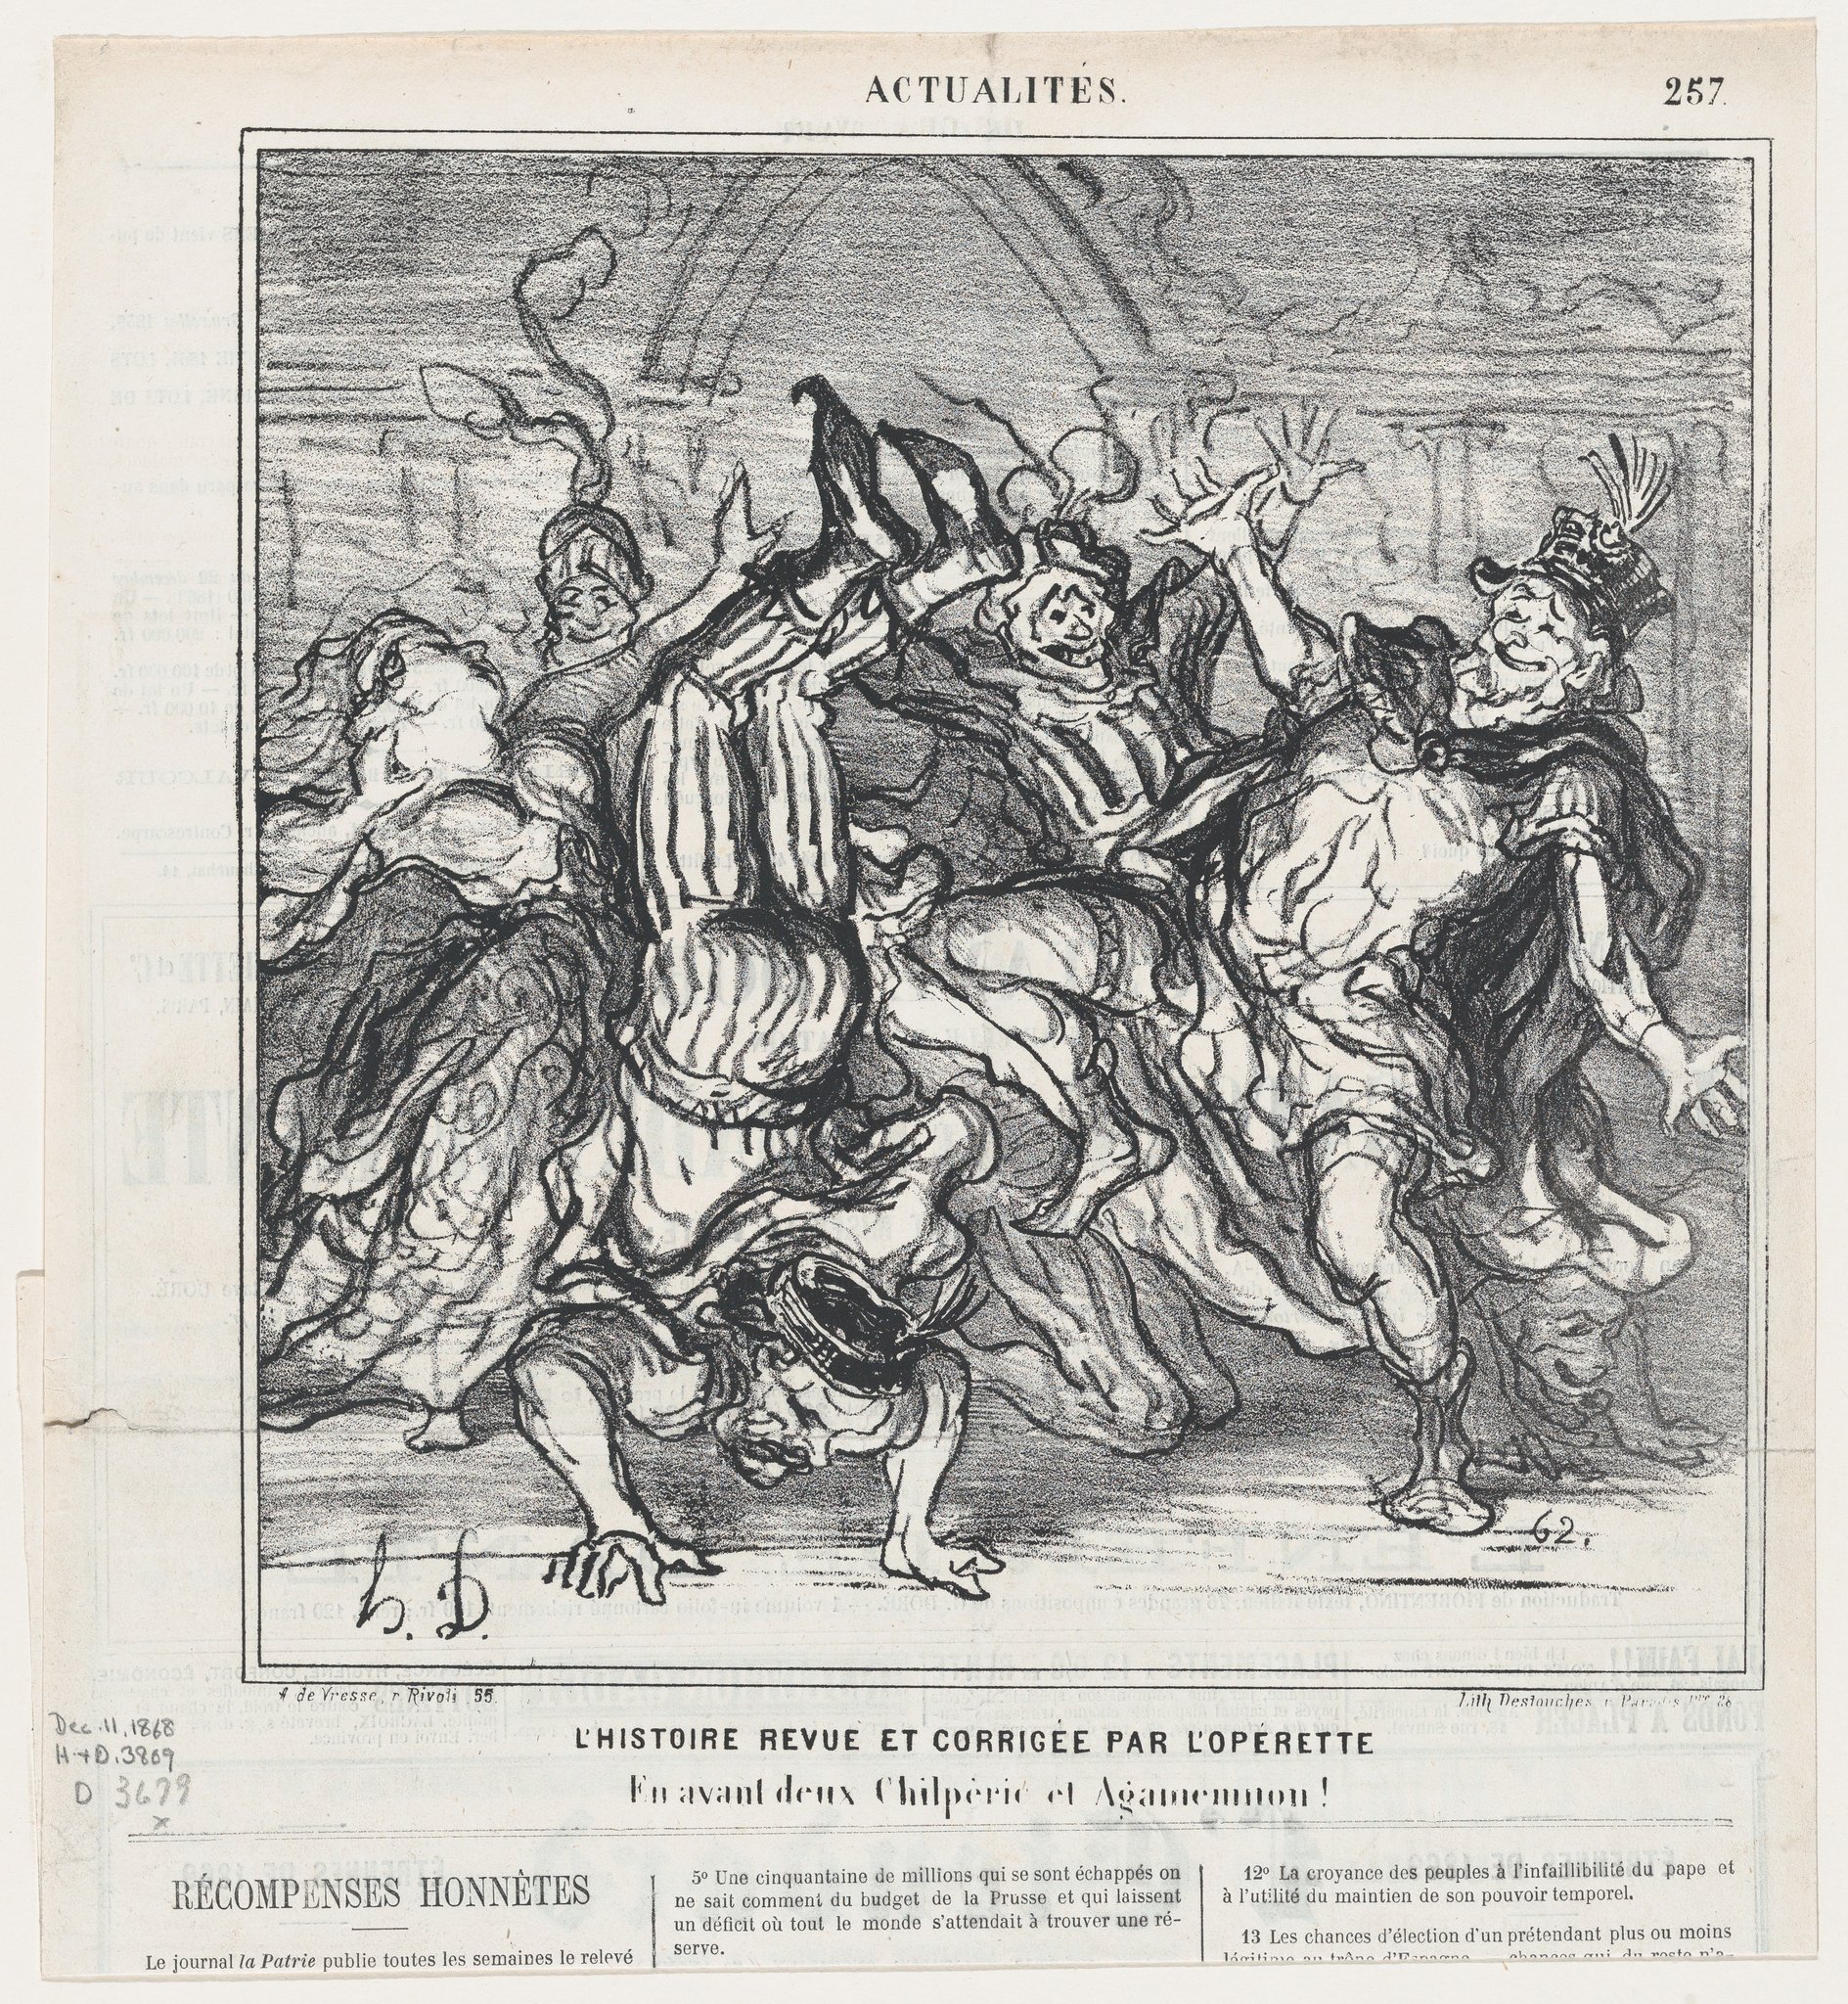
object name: print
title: History revised and corrected by the operetta: Go ahead Chilperic and Agamemnon!, from 'News of the day,' published in Le Charivari, December 11, 1868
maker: honoré daumier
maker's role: artist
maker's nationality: french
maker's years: 1808-1879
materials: paper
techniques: lithograph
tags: satire,men,dancing